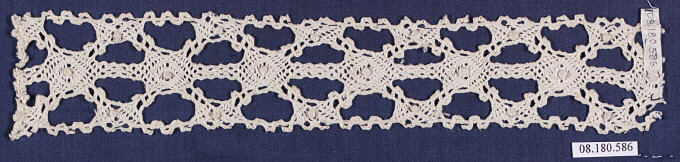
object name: fragment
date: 1501-1600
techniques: lace